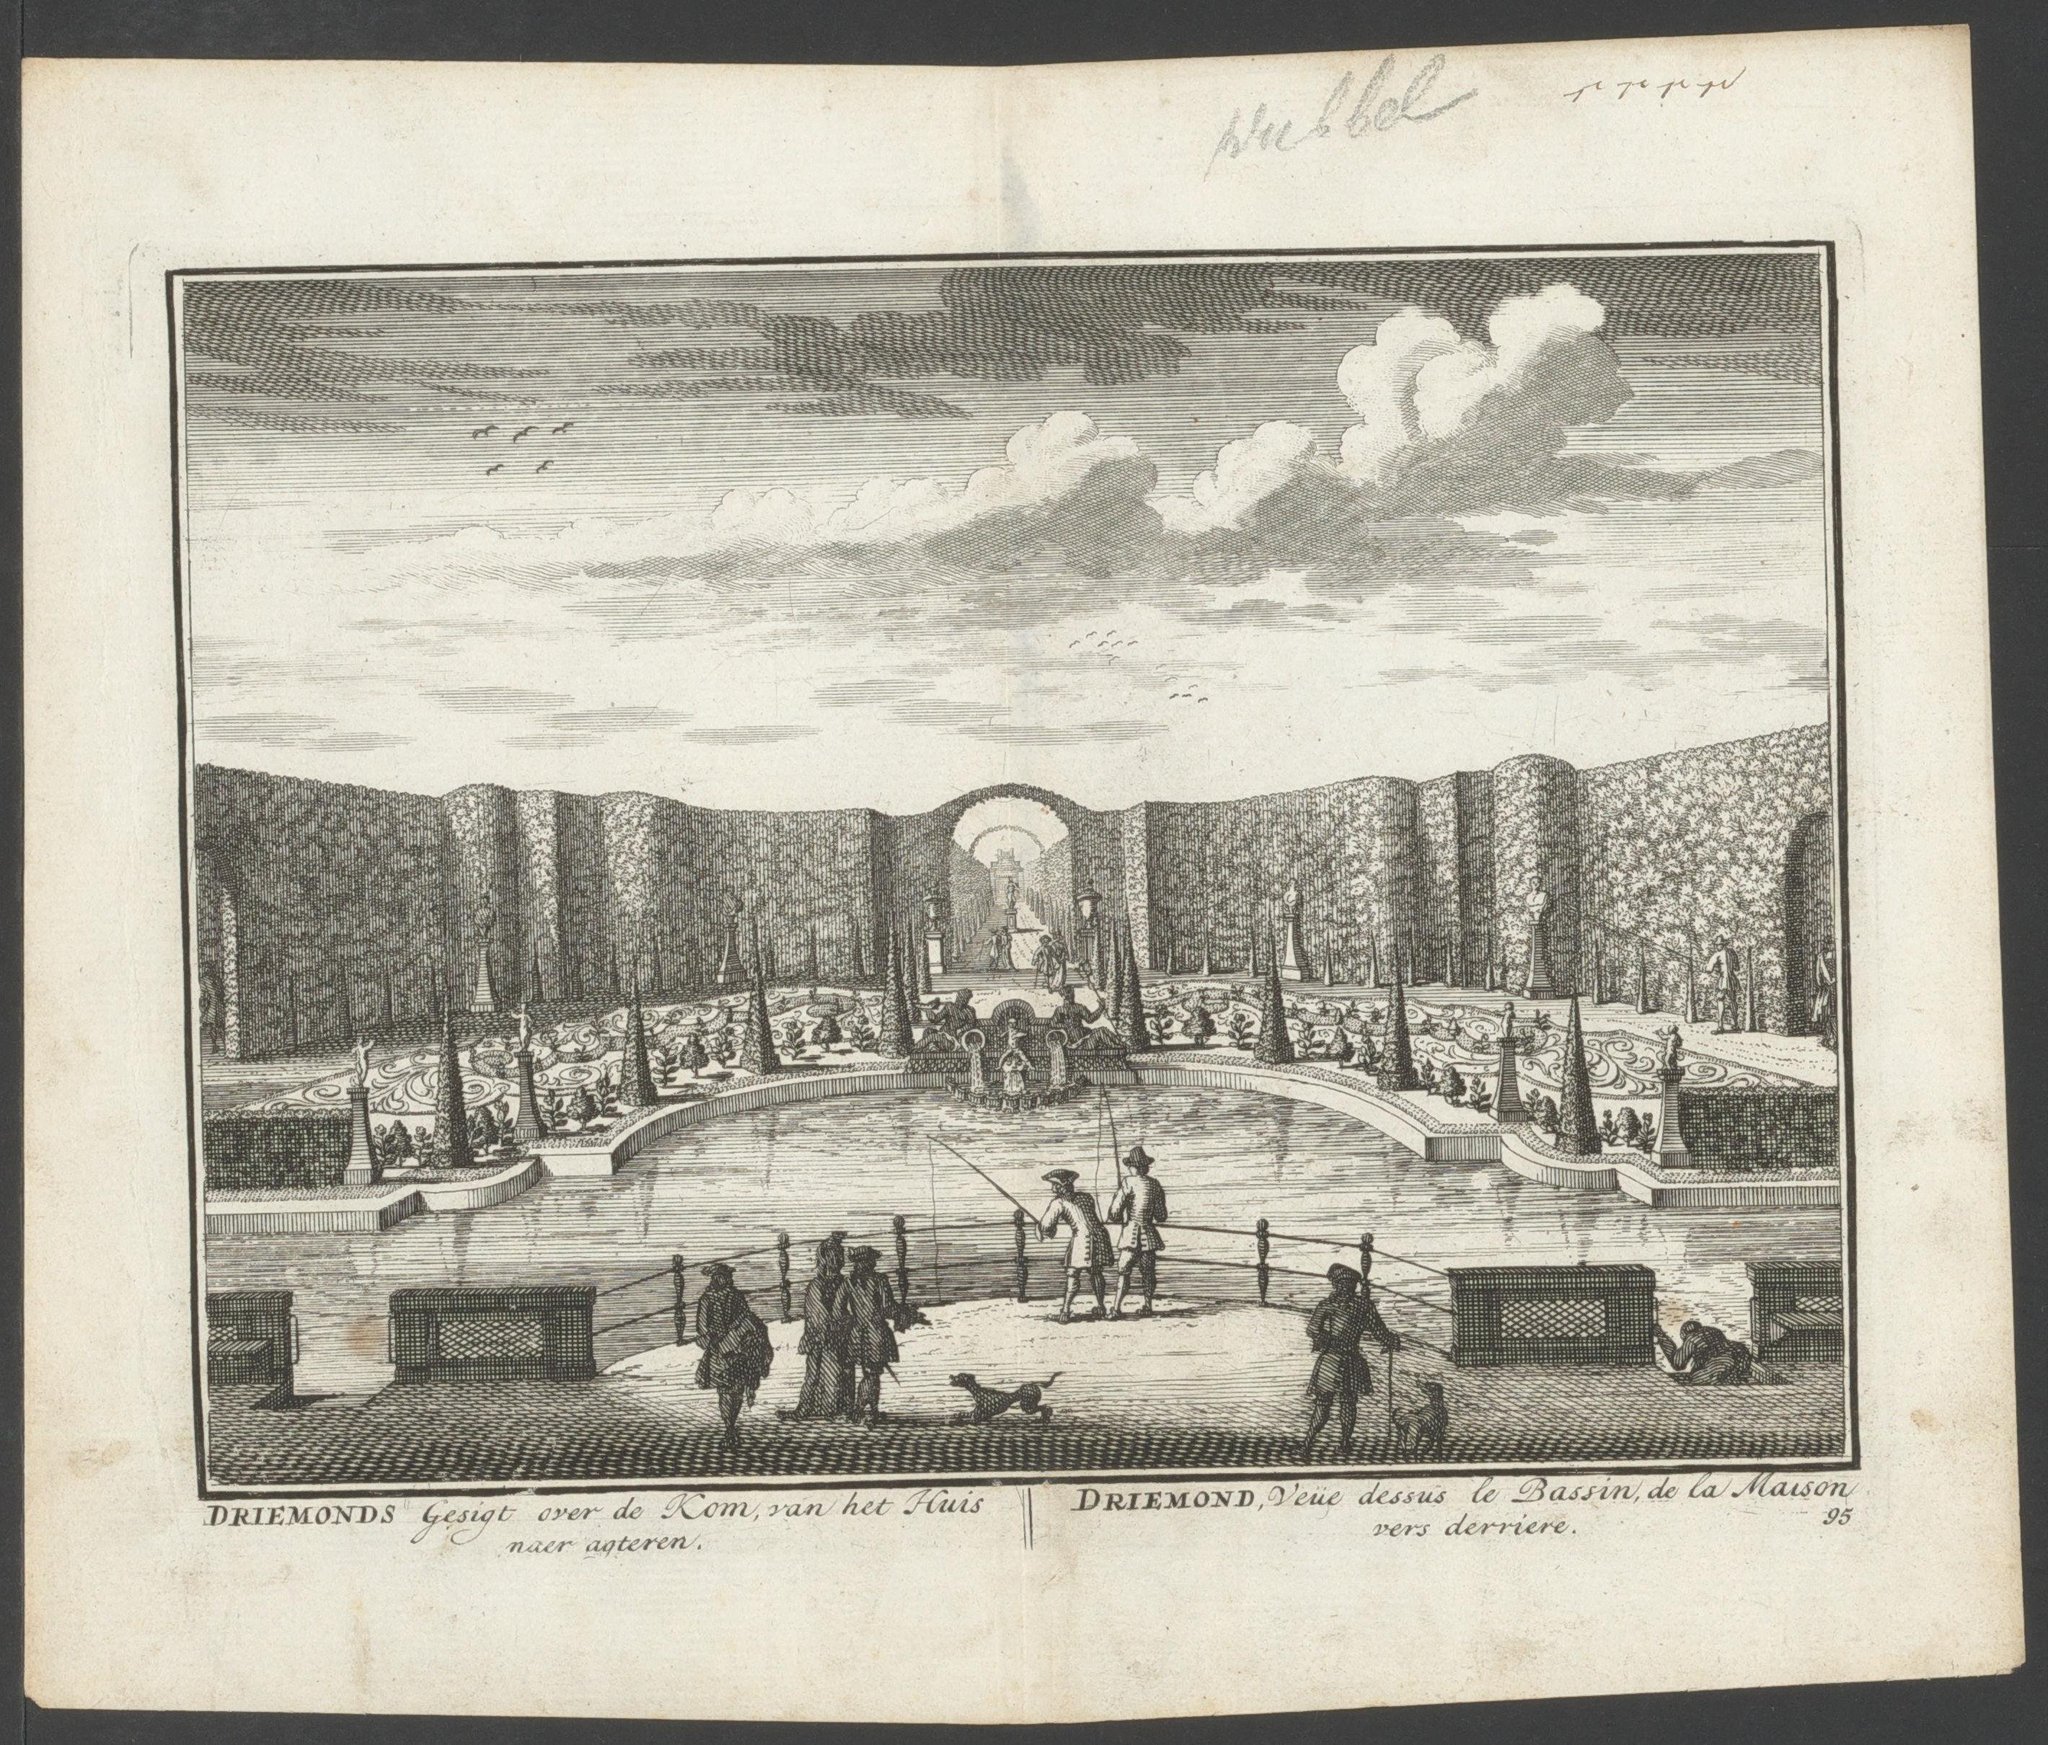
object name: print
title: Driemonds Gesigt over de Kom, van het Huis naer agteren / Driemonds, Veüe dessus le Bassin, de la Maison vers derriere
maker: daniël stopendaal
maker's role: print maker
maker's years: 1672-1726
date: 1790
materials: paper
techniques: engraving, etching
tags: french or architectonic garden; formal garden, garden pond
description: Prent voor het eerst gebruikt in: Leth, Andries de. De zegepraalende Vecht, vertoonende verscheidene gesichten van lustplaatsen, heeren huysen en dorpen, beginnende van Uitrecht en met Muyden besluytende (...). Amsterdam: Weduwe Nicolaus Visscher, 1719. Prent mogelijk uit: Brouërius van Nidek, Matthaeus. De Vechtstroom, van Utrecht tot Muiden (...). Amsterdam: H. Gartman, W. Vermandel en J.W. Smit, 1790.